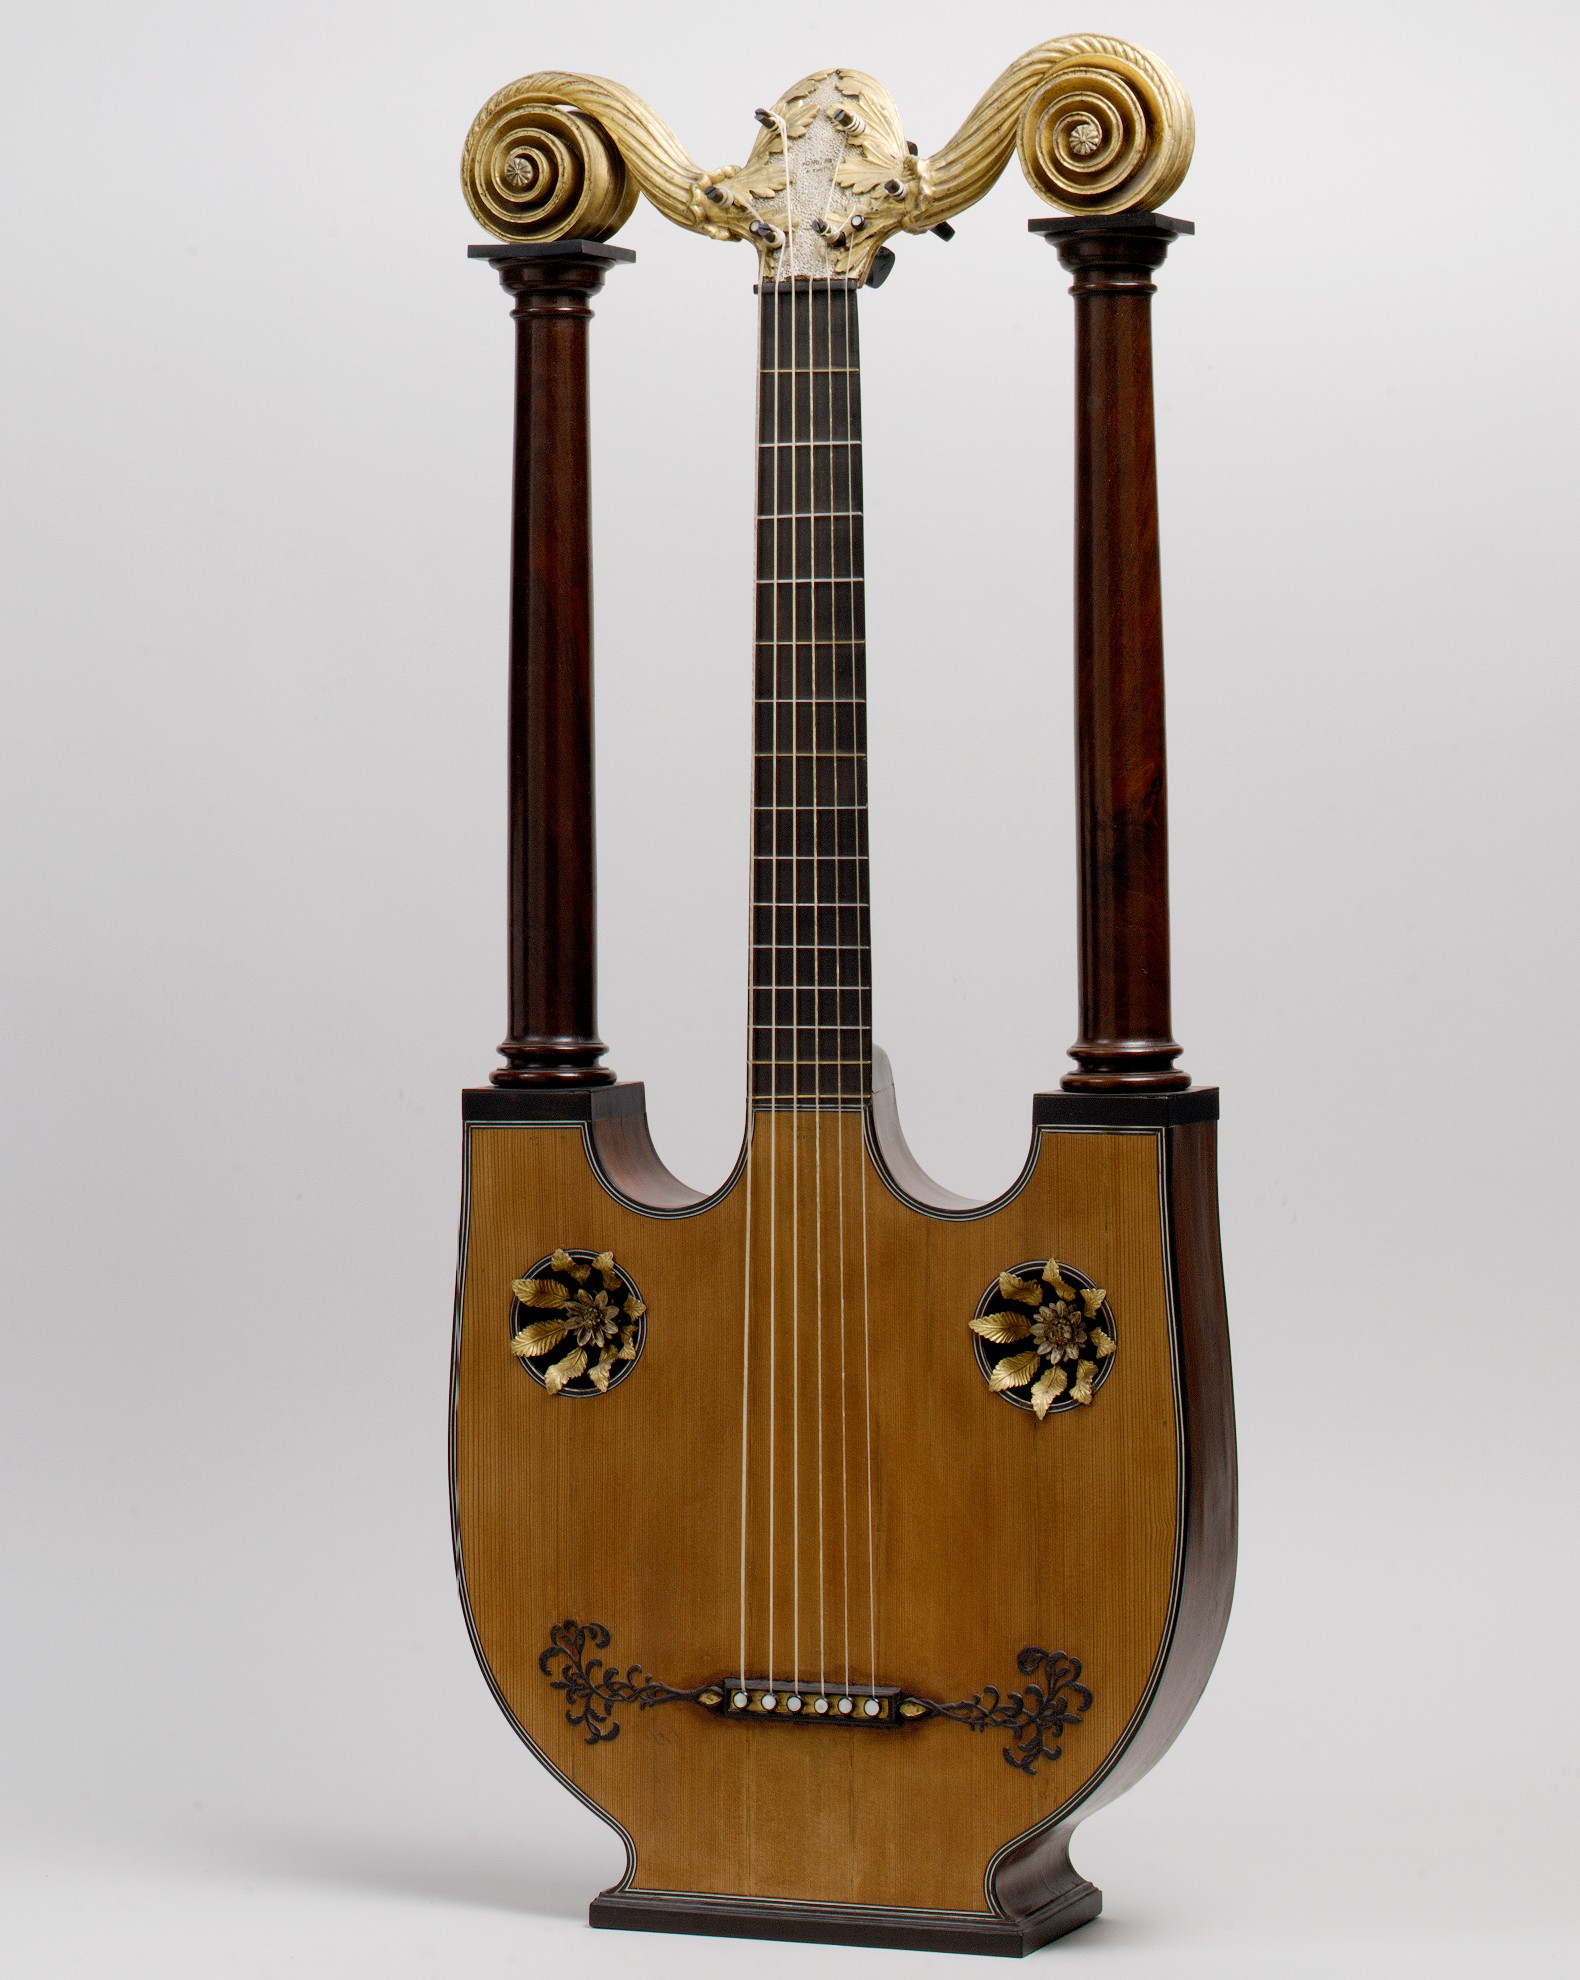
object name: lyre guitar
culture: french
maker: joseph pons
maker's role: maker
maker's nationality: french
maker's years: 1776-1876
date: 1805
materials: brass, wood, nickel, silver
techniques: gilding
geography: france